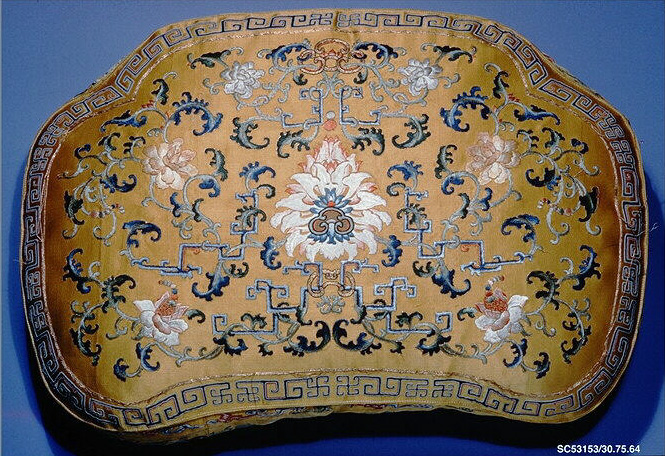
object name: cushion cover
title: On of a Pair of Cushion Covers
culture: chinese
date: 1736-1795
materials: metal thread, silk